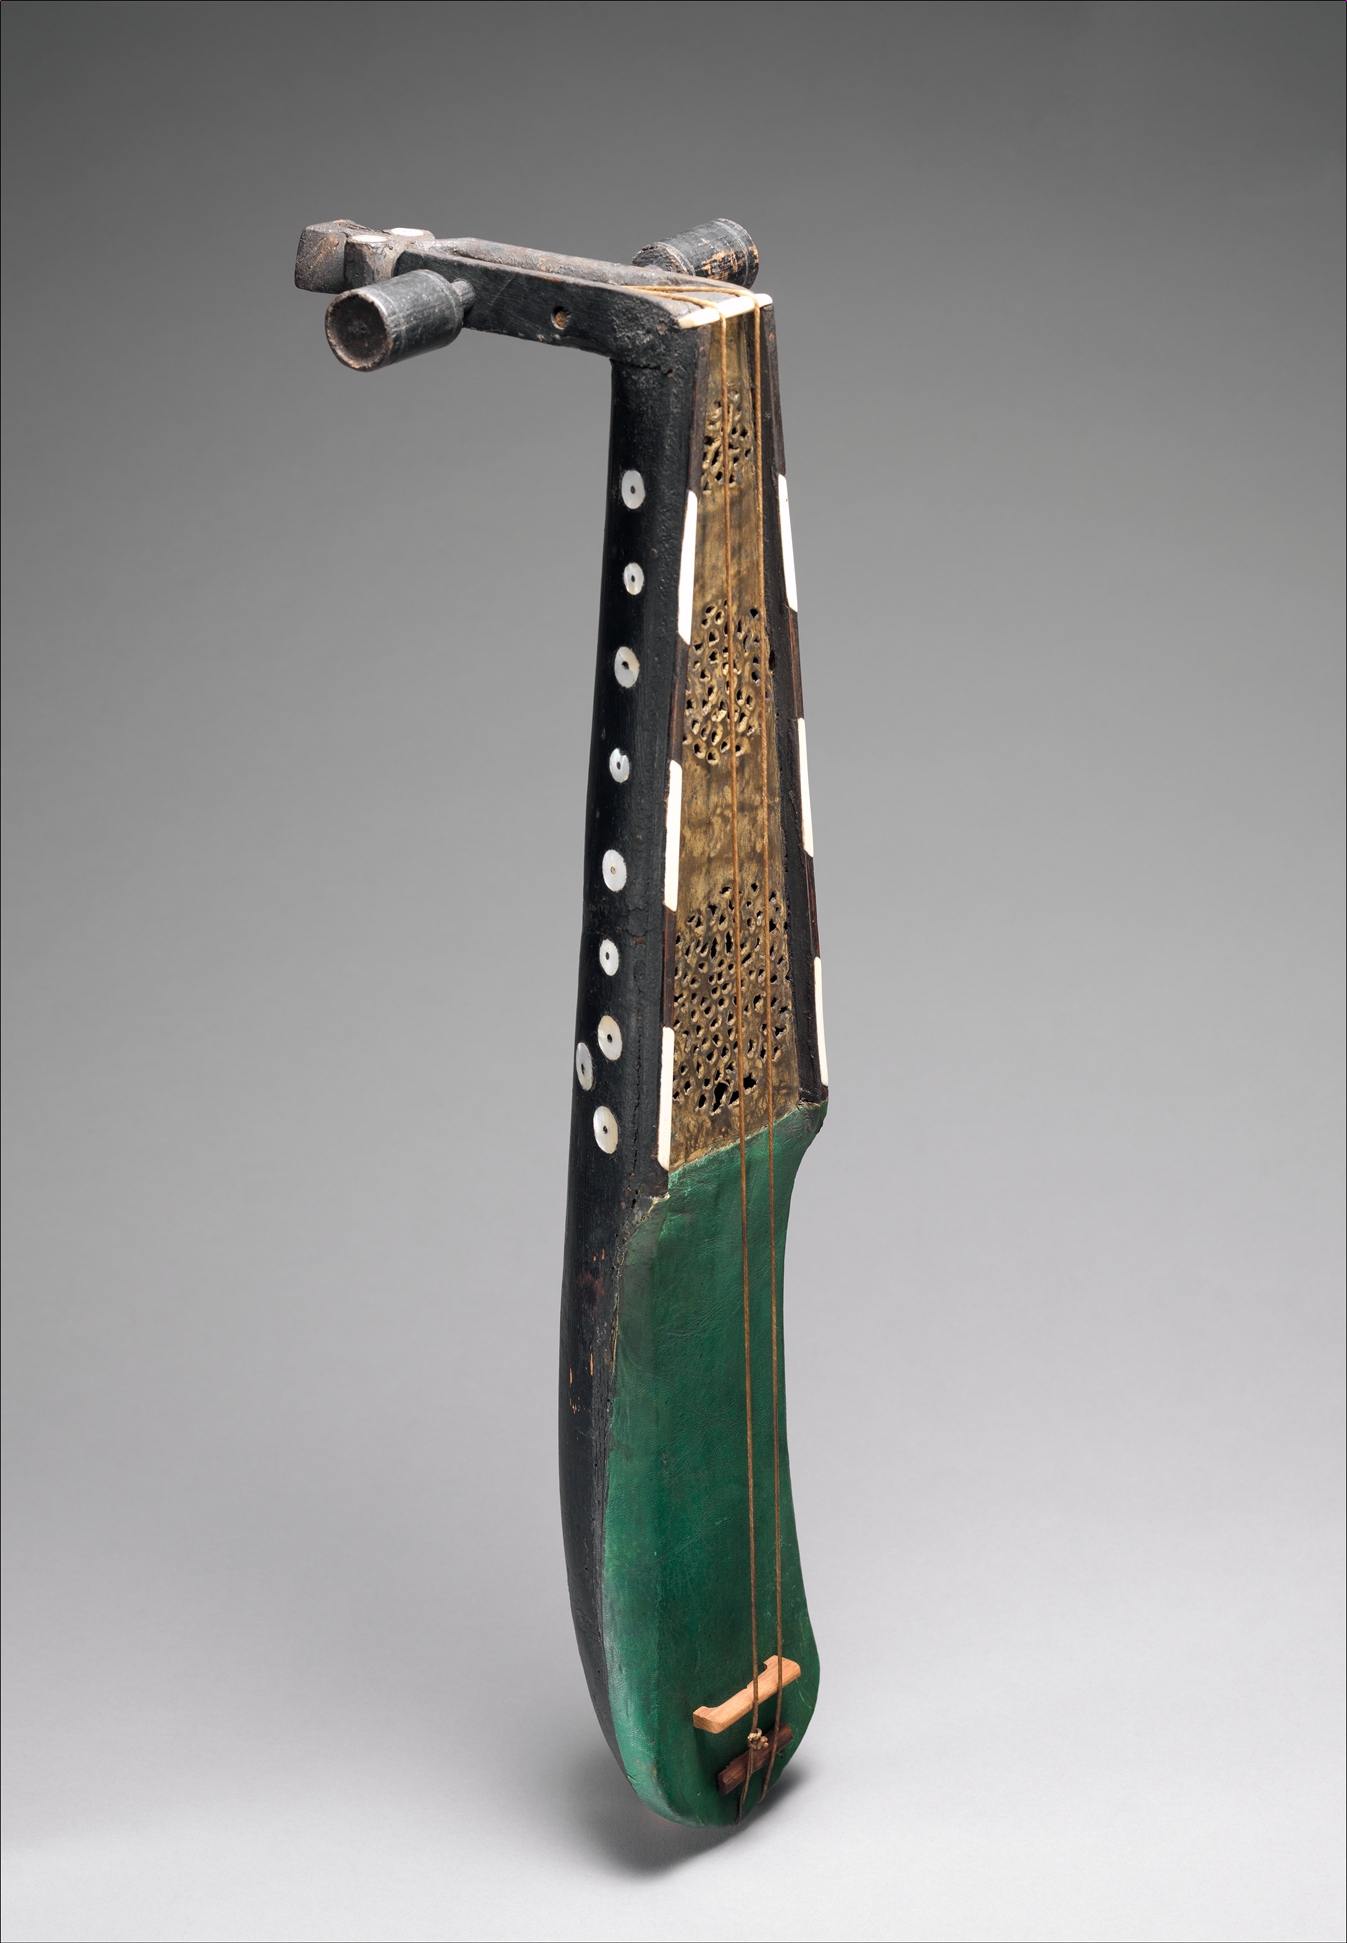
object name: rebab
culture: algerian or moroccan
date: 1867-1900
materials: metal, parchment, wood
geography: algeria